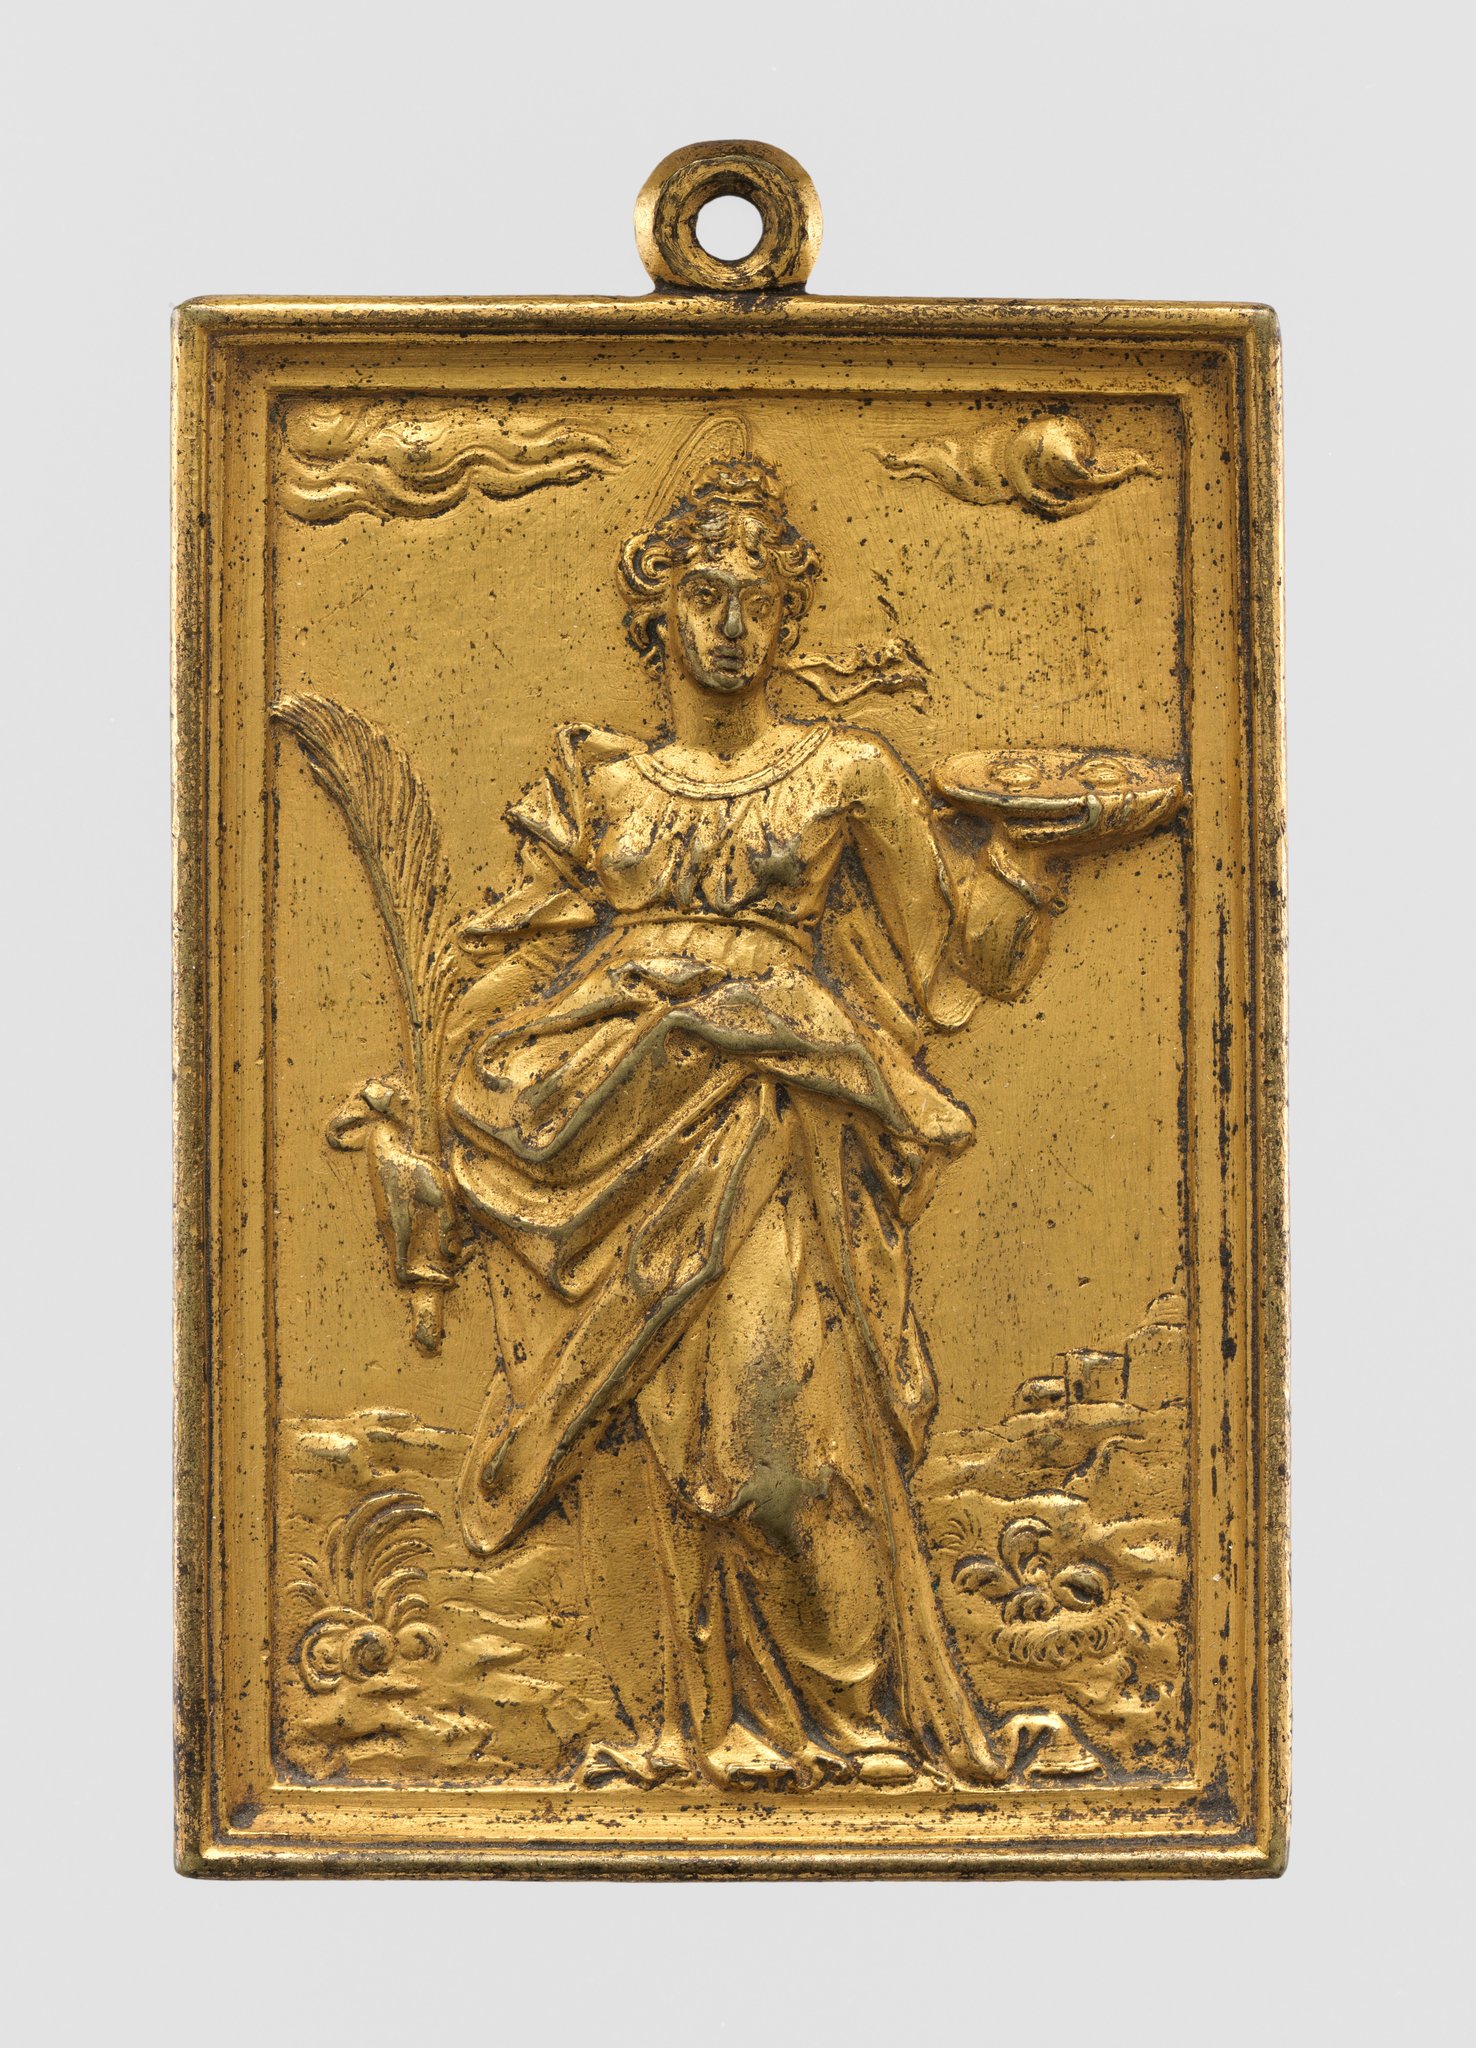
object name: plaquette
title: Saint Lucy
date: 1601-1700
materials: gilt bronze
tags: women,saints